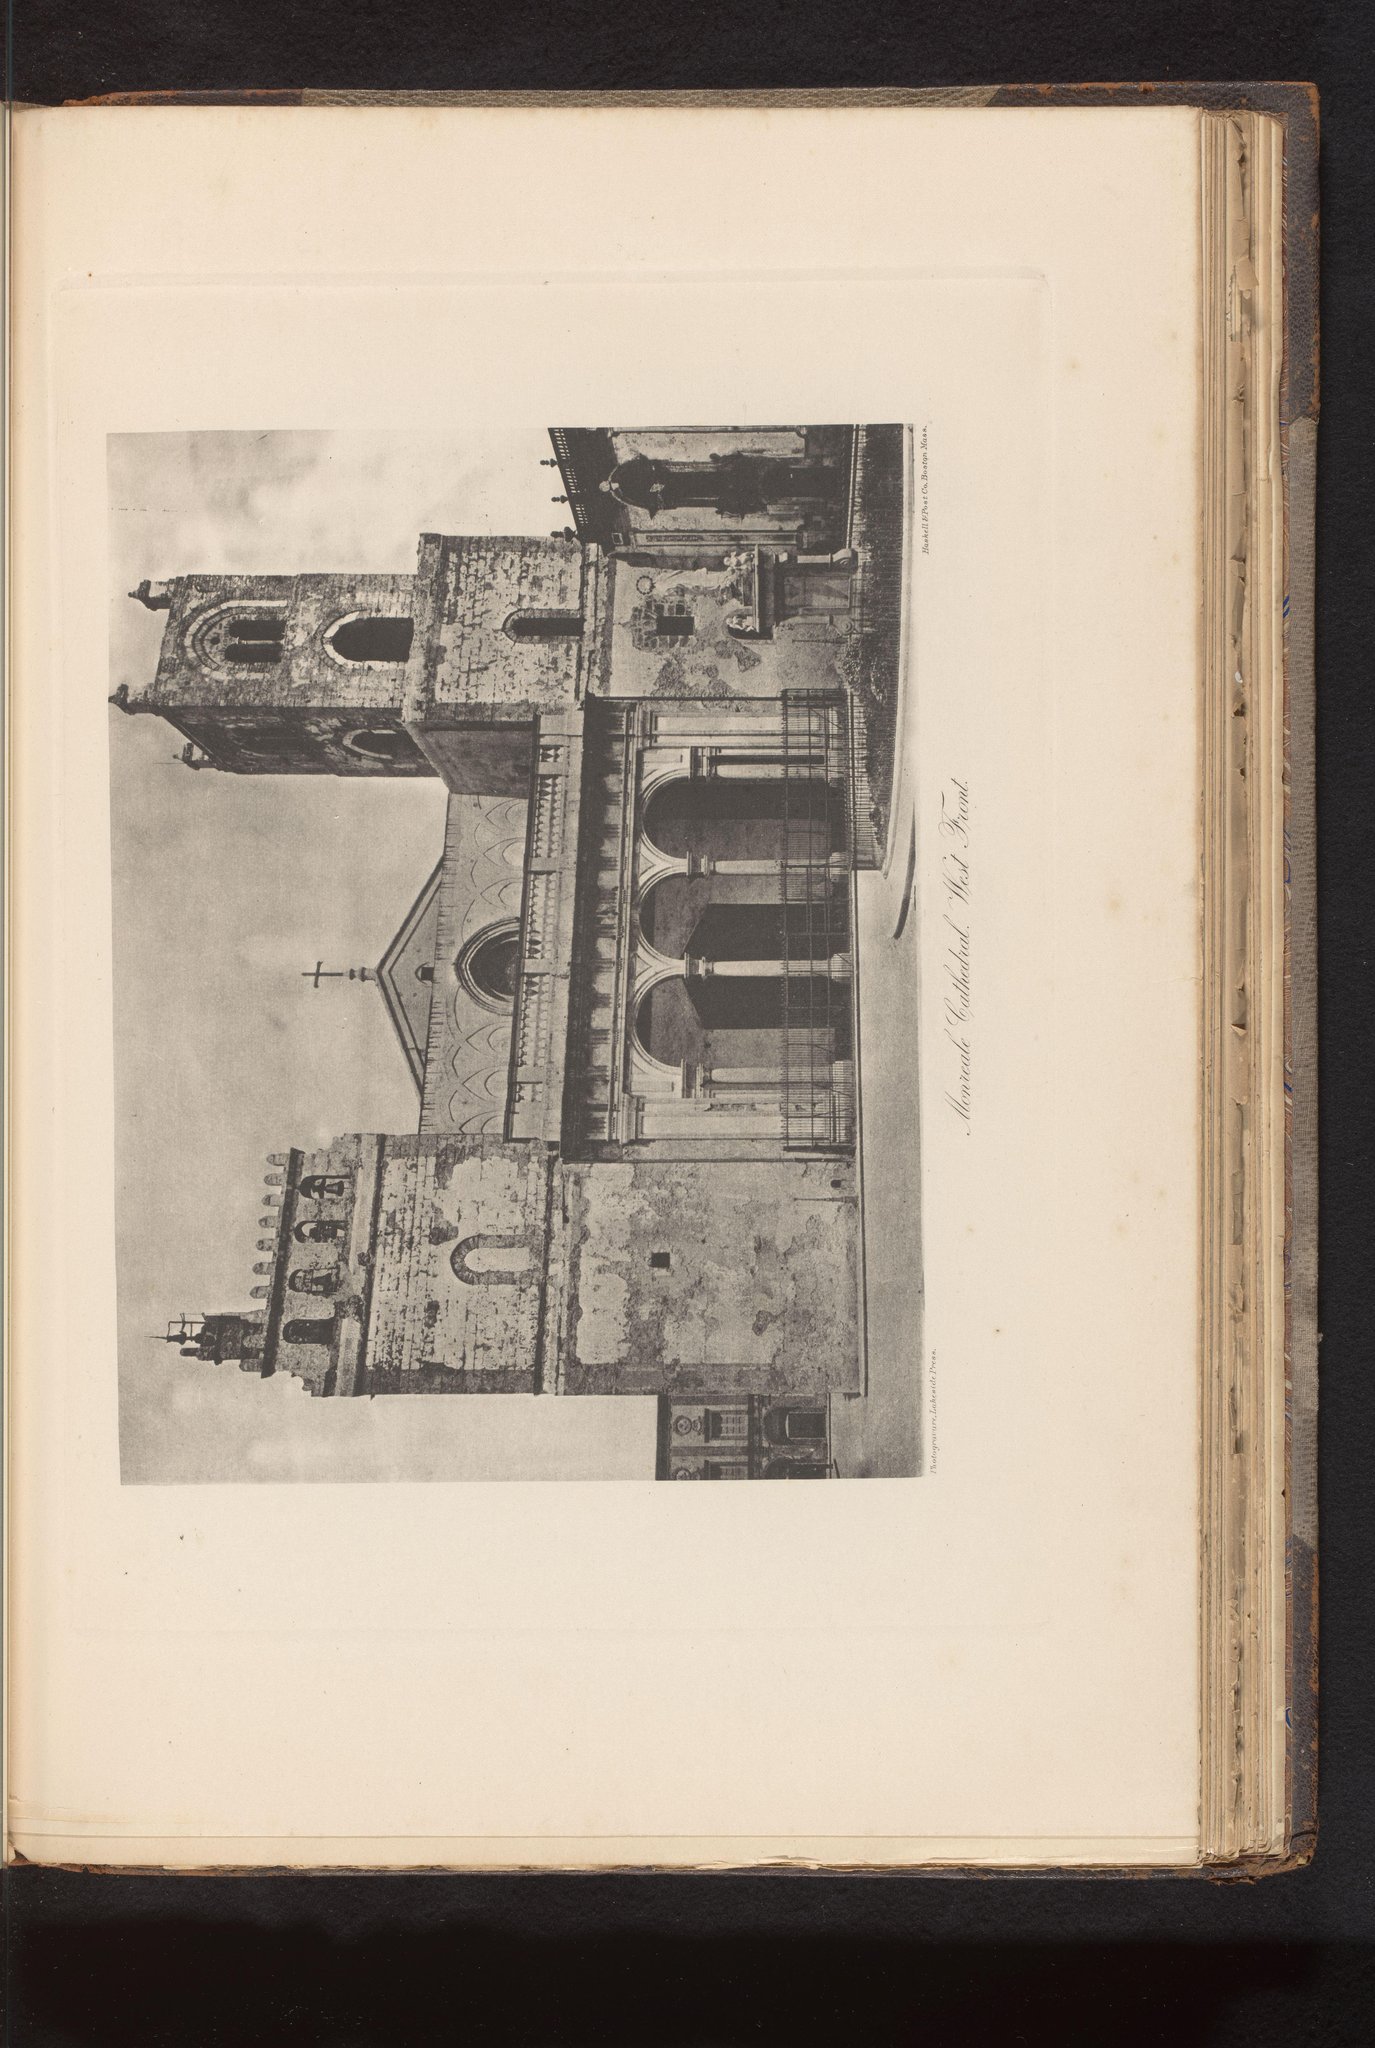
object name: page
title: Westzijde van de kathedraal van Monreale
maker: Anonymous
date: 1881-1886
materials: paper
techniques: photograph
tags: church (exterior), façade (of house or building)